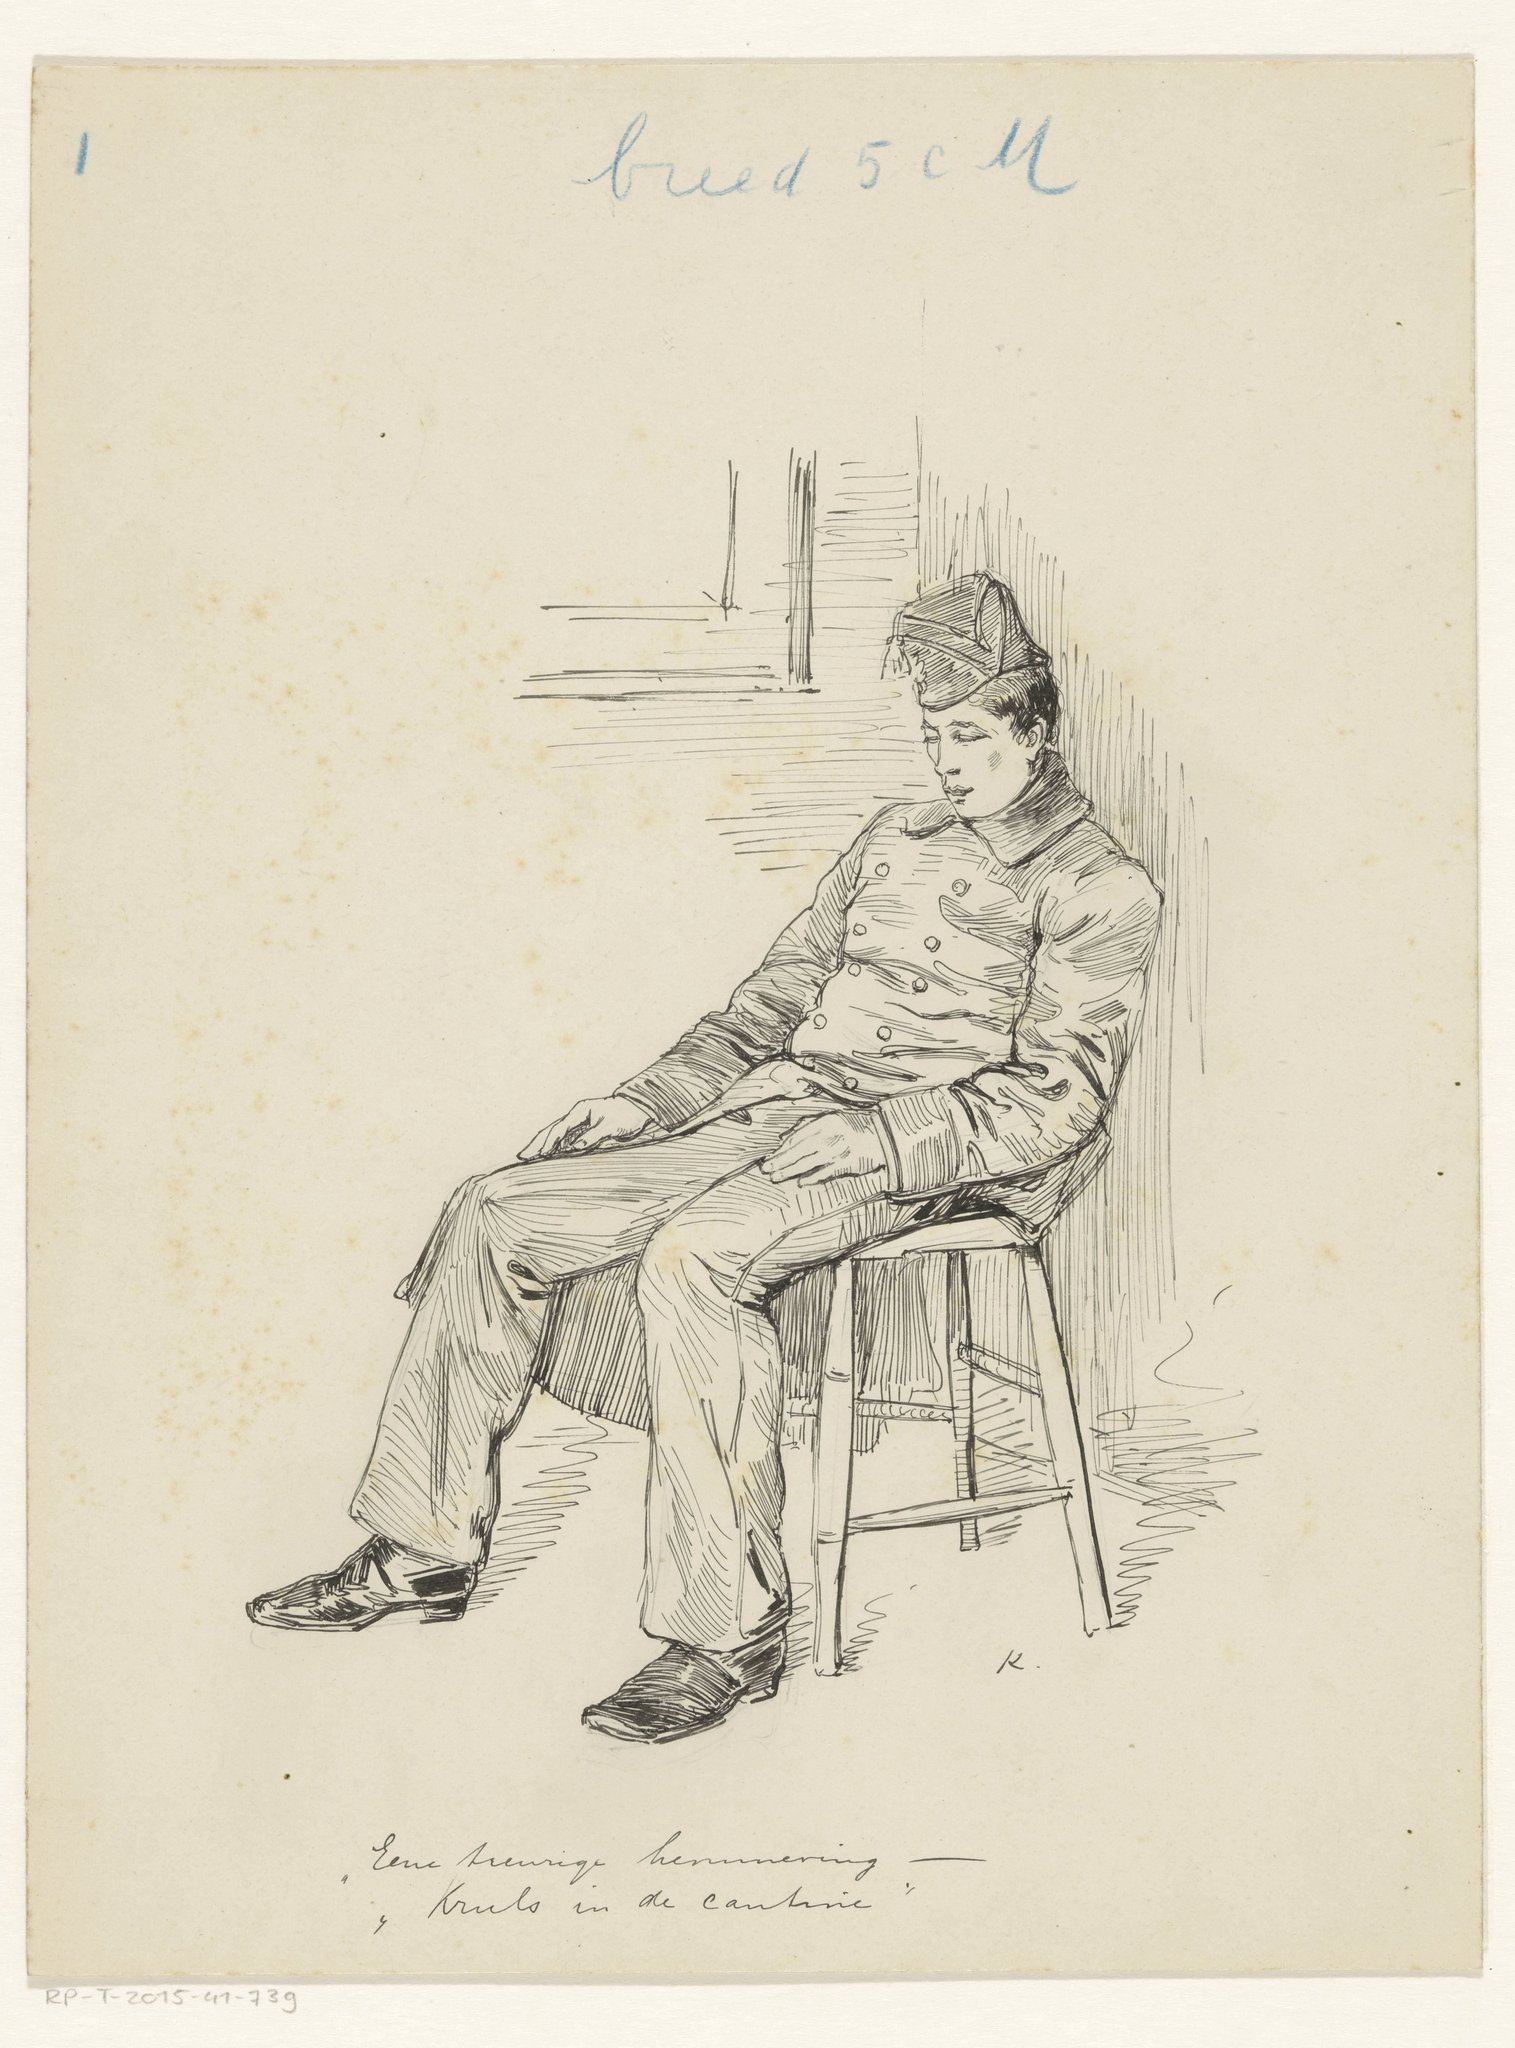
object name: boekillustratie ontwerp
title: Soldaat zittend op een kruk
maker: heinrich m. krabbé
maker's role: draughtsman, print maker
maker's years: 1868-1931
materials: cardboard, ink, pencil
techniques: pen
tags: stool, eyes closed, the soldier; the soldier's life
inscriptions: annotation: ‘"Eene treurige herinnering -/ "Kruls in de ca[...]ie"’, :, collector's mark: Lugt 2228, signature: ‘K.’, number: ‘1’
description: Een jonge soldaat zit met gesloten ogen op een kruk en leunt met zijn rug tegen een muur.